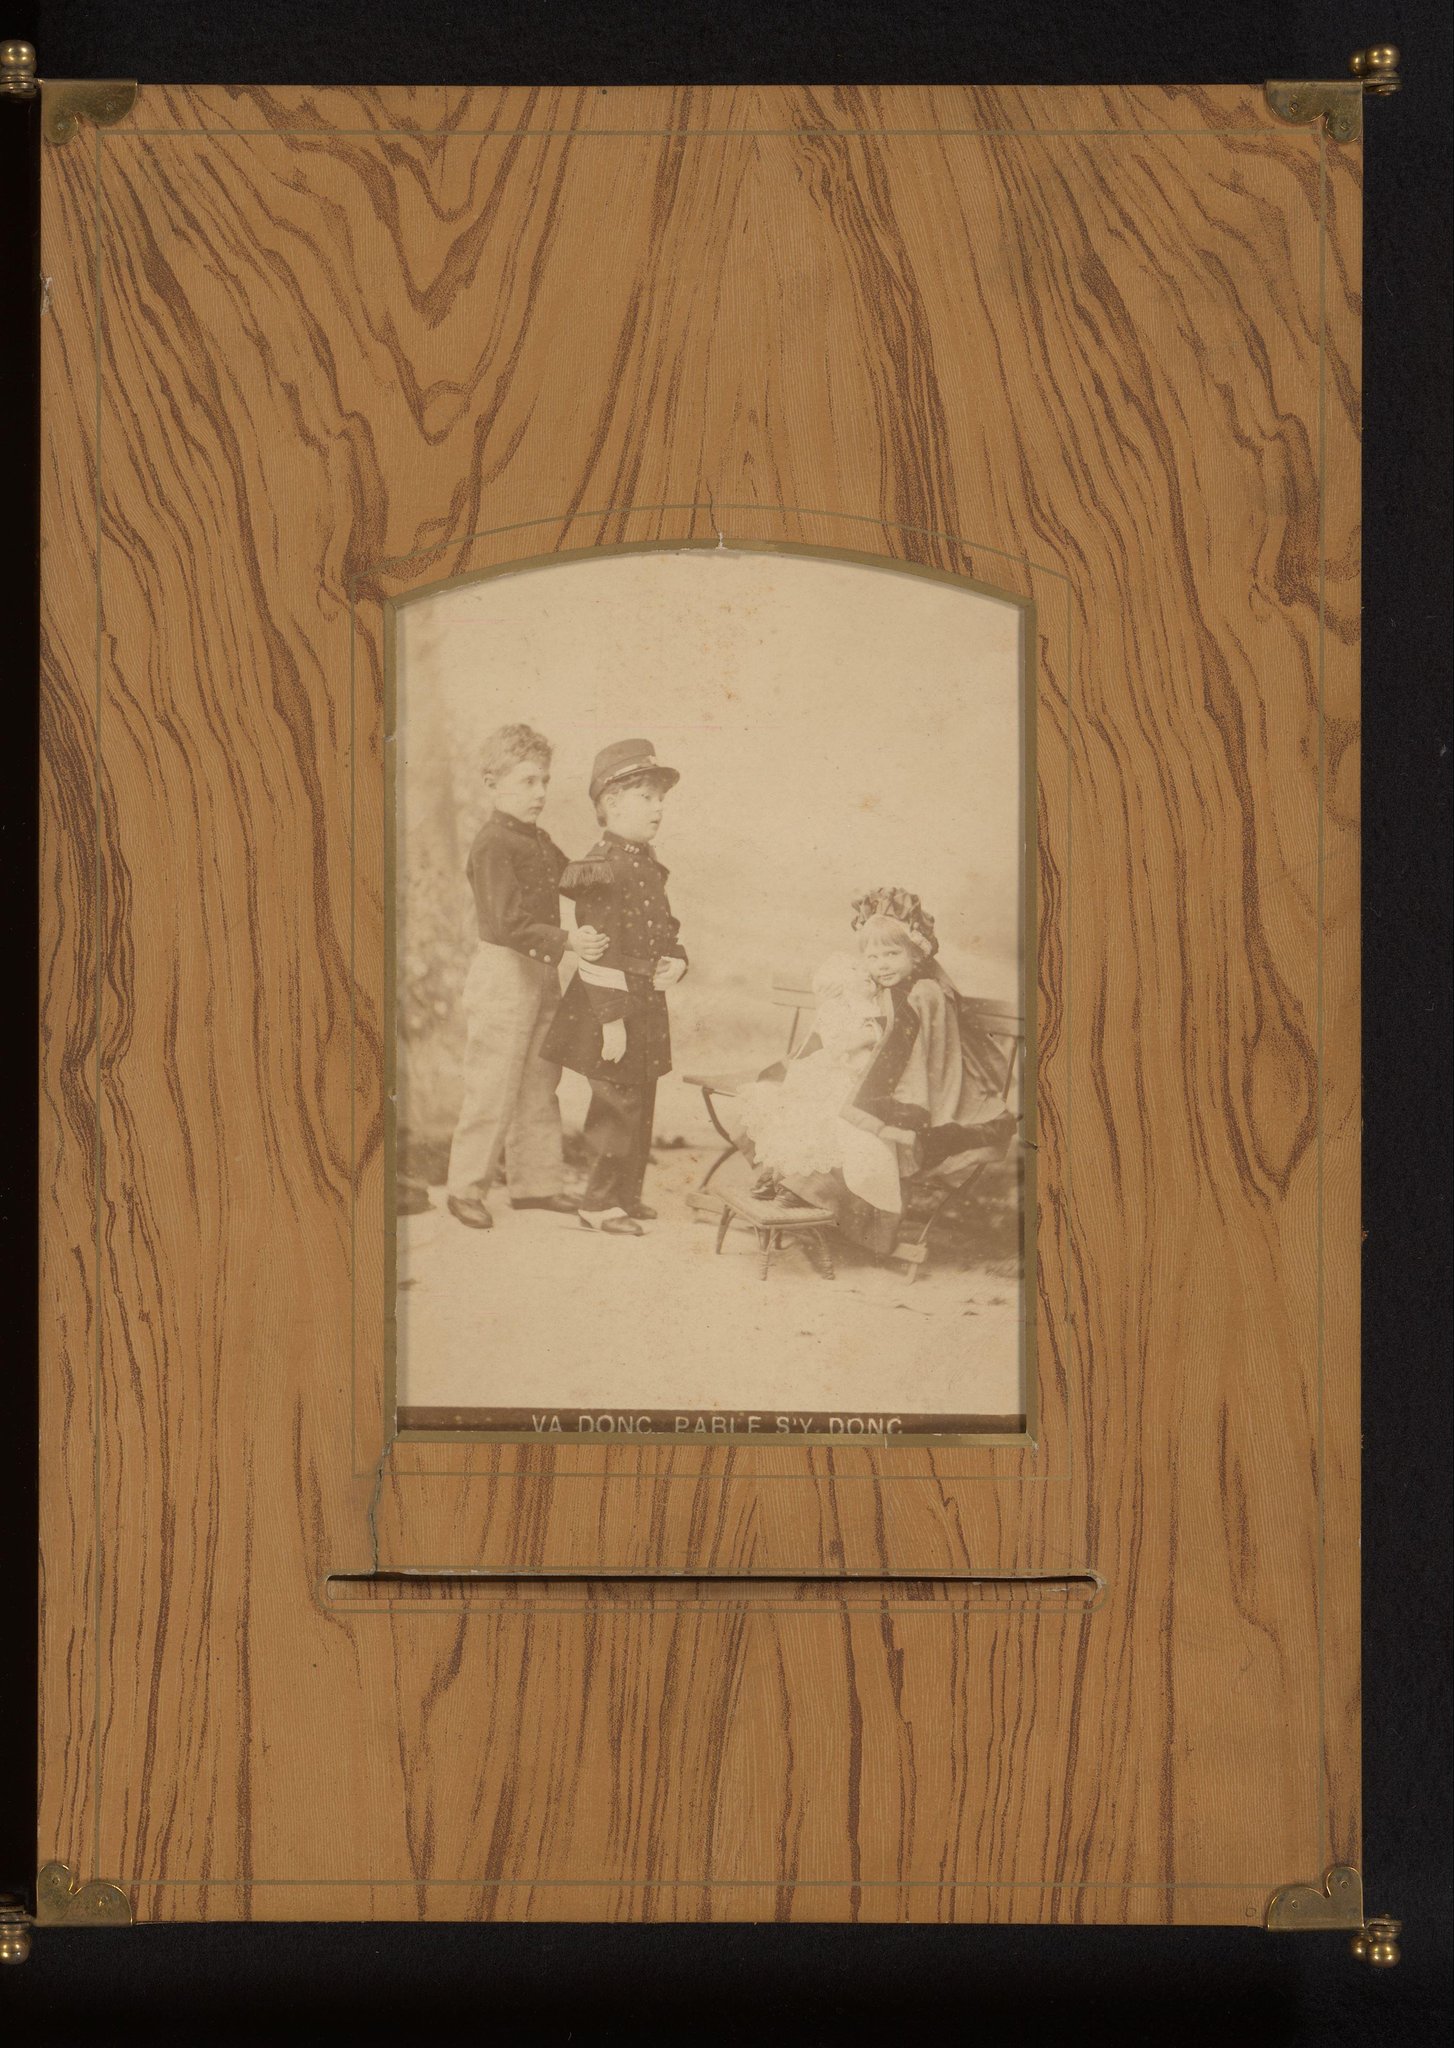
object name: cabinet photograph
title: Portret van drie kinderen tijdens een toneelspel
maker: a. courrier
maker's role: fotograaf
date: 1887-1900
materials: cardboard, photographic support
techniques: albumen print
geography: paris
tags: theatre, theatrical performance, child (+ three persons), anonymous historical persons portrayed in a group, in a group-portrait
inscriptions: inscription: ‘PARIS/ 1886./ Médaille d'Argent/ Hâvre 1887/ Mon. L. Bacard/ A. courrier/ Successeur/ SPÉCIALITÉ/ DE PORTRAITS D'ENFANTS/ 59, Rue de Rivoli, 59./ Paris’, number: ‘280 - d’